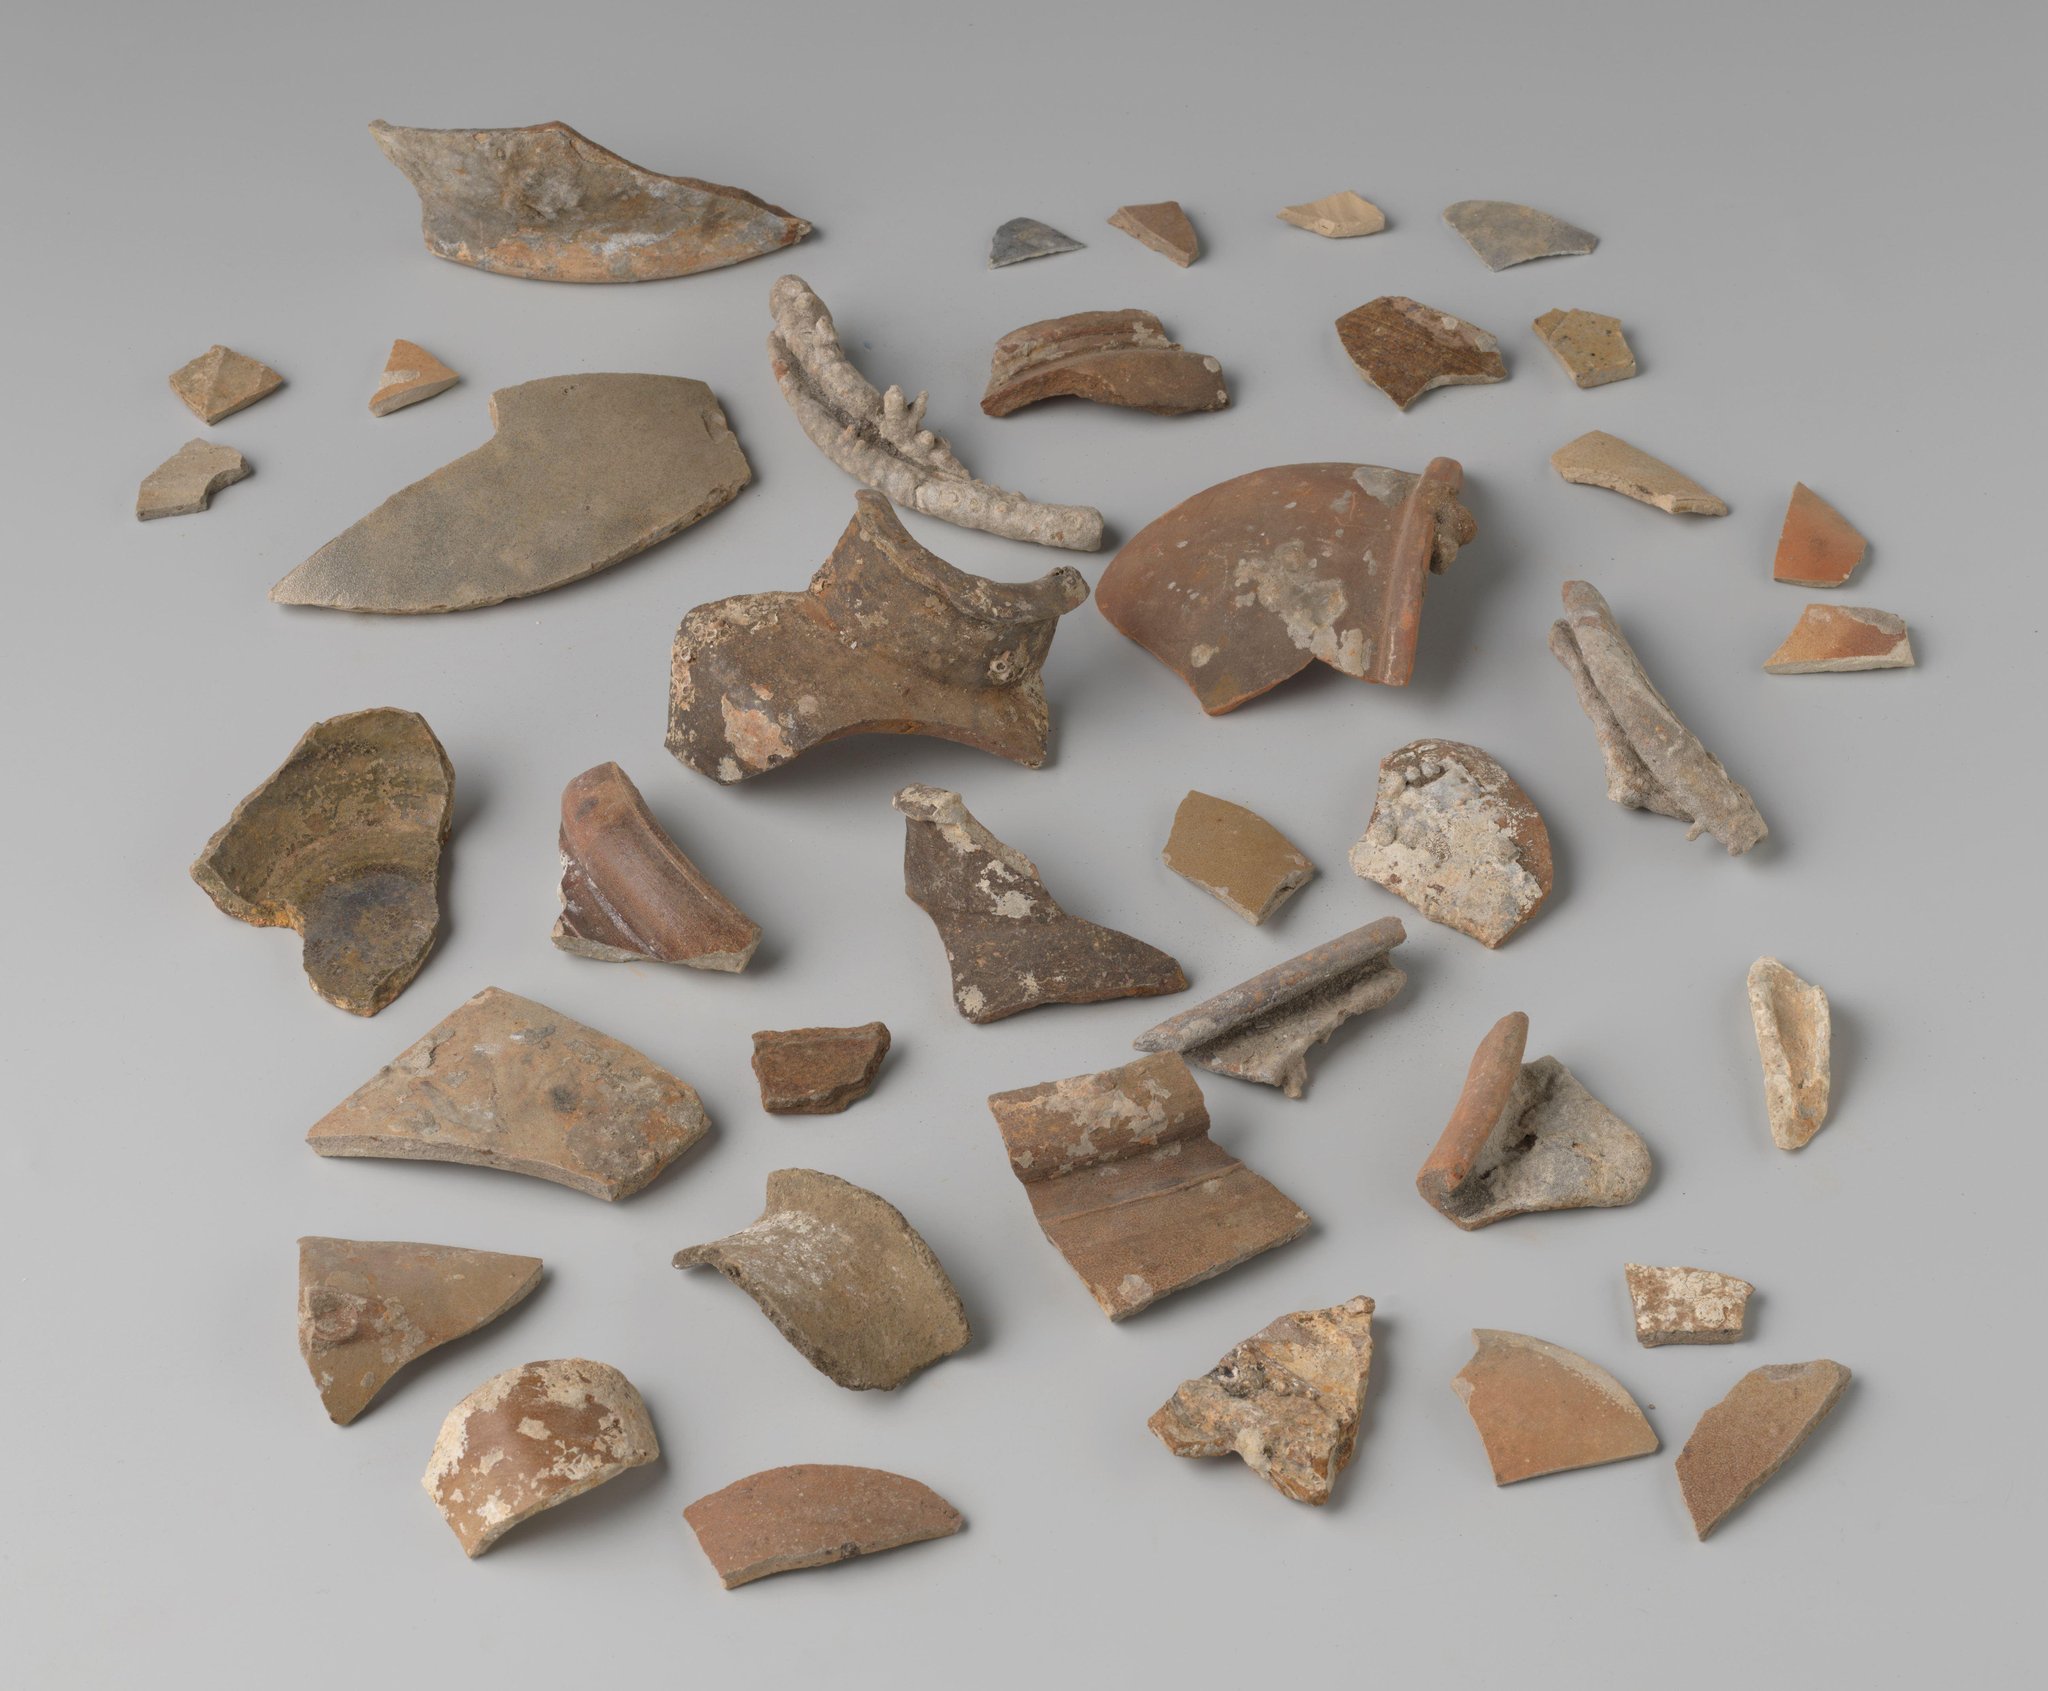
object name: sherd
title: Scherven aardewerk en steengoed uit V.O.C.-schip de 'Witte Leeuw'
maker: Anonymous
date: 1613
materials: earthenware, glaze, stoneware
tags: verenigde oostindische compagnie, sint-helena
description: Ongeglazuurde en geglazuurde scherven aardewerk en steengoed uit V.O.C.-schip de 'Witte Leeuw'.